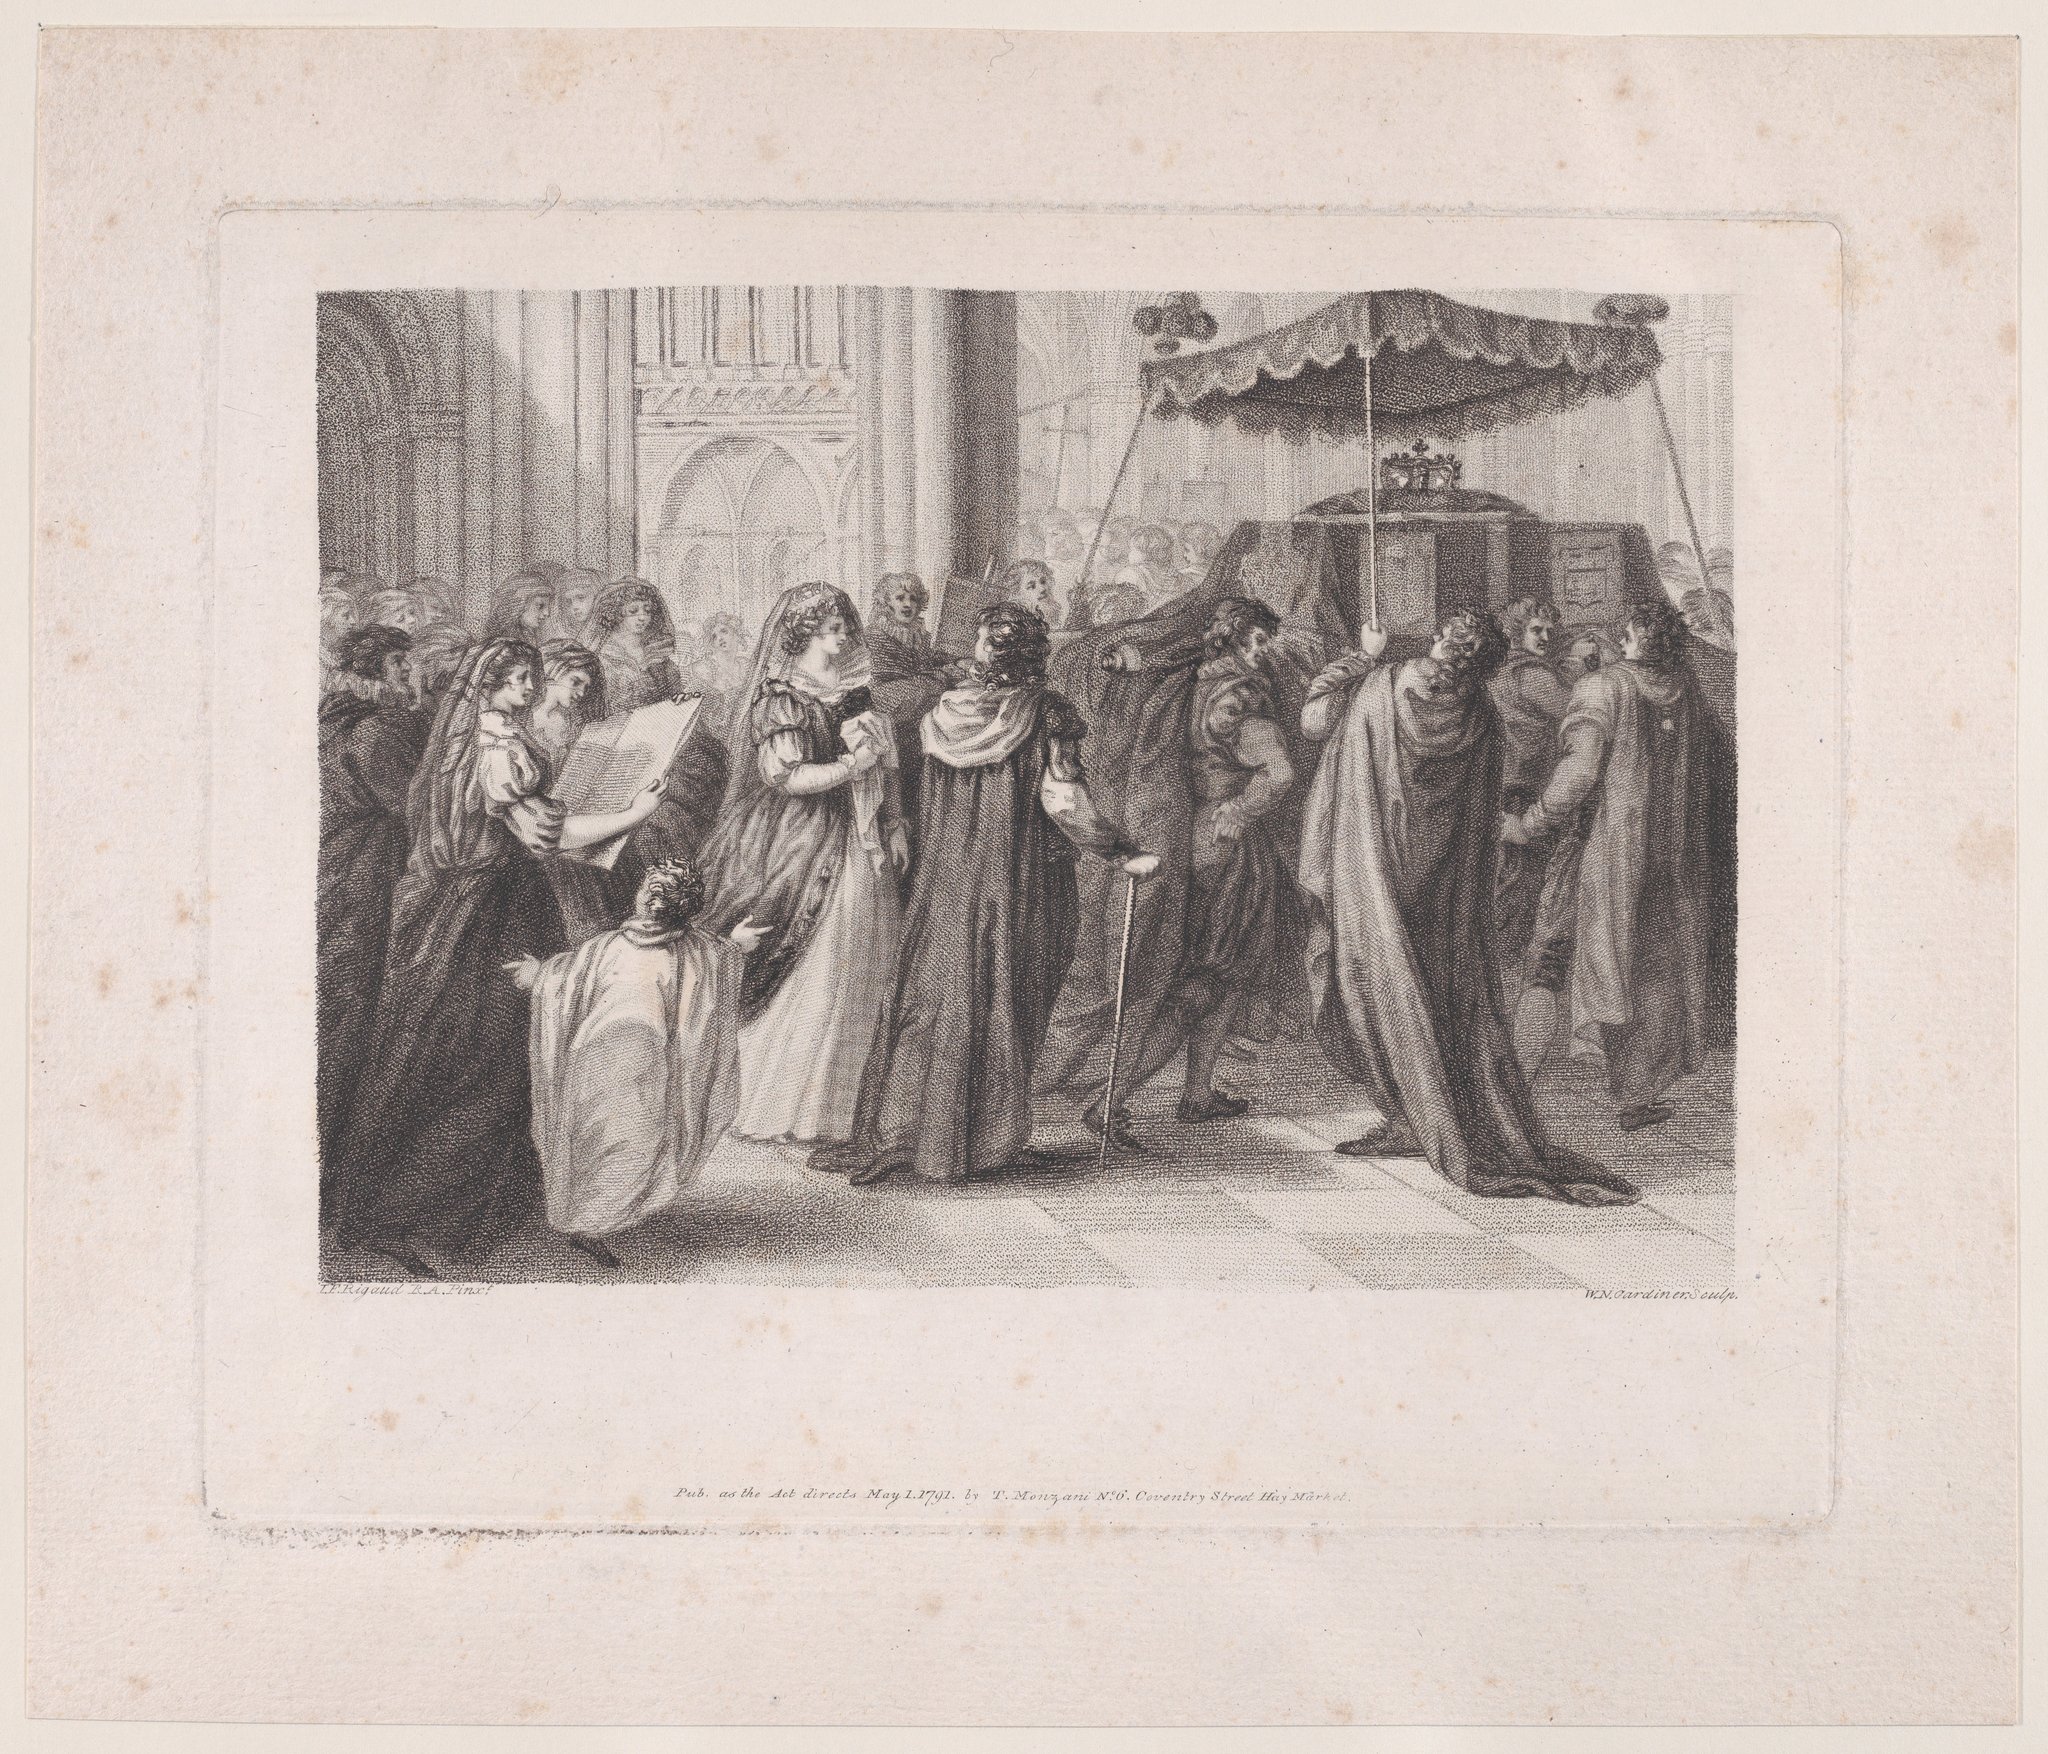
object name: print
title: Funeral procession of Mary, Queen of Scots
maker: william nelson gardiner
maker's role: artist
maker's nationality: british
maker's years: 1766-1814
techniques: engraving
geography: england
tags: men,women,coffins,funerals,mary queen of scots